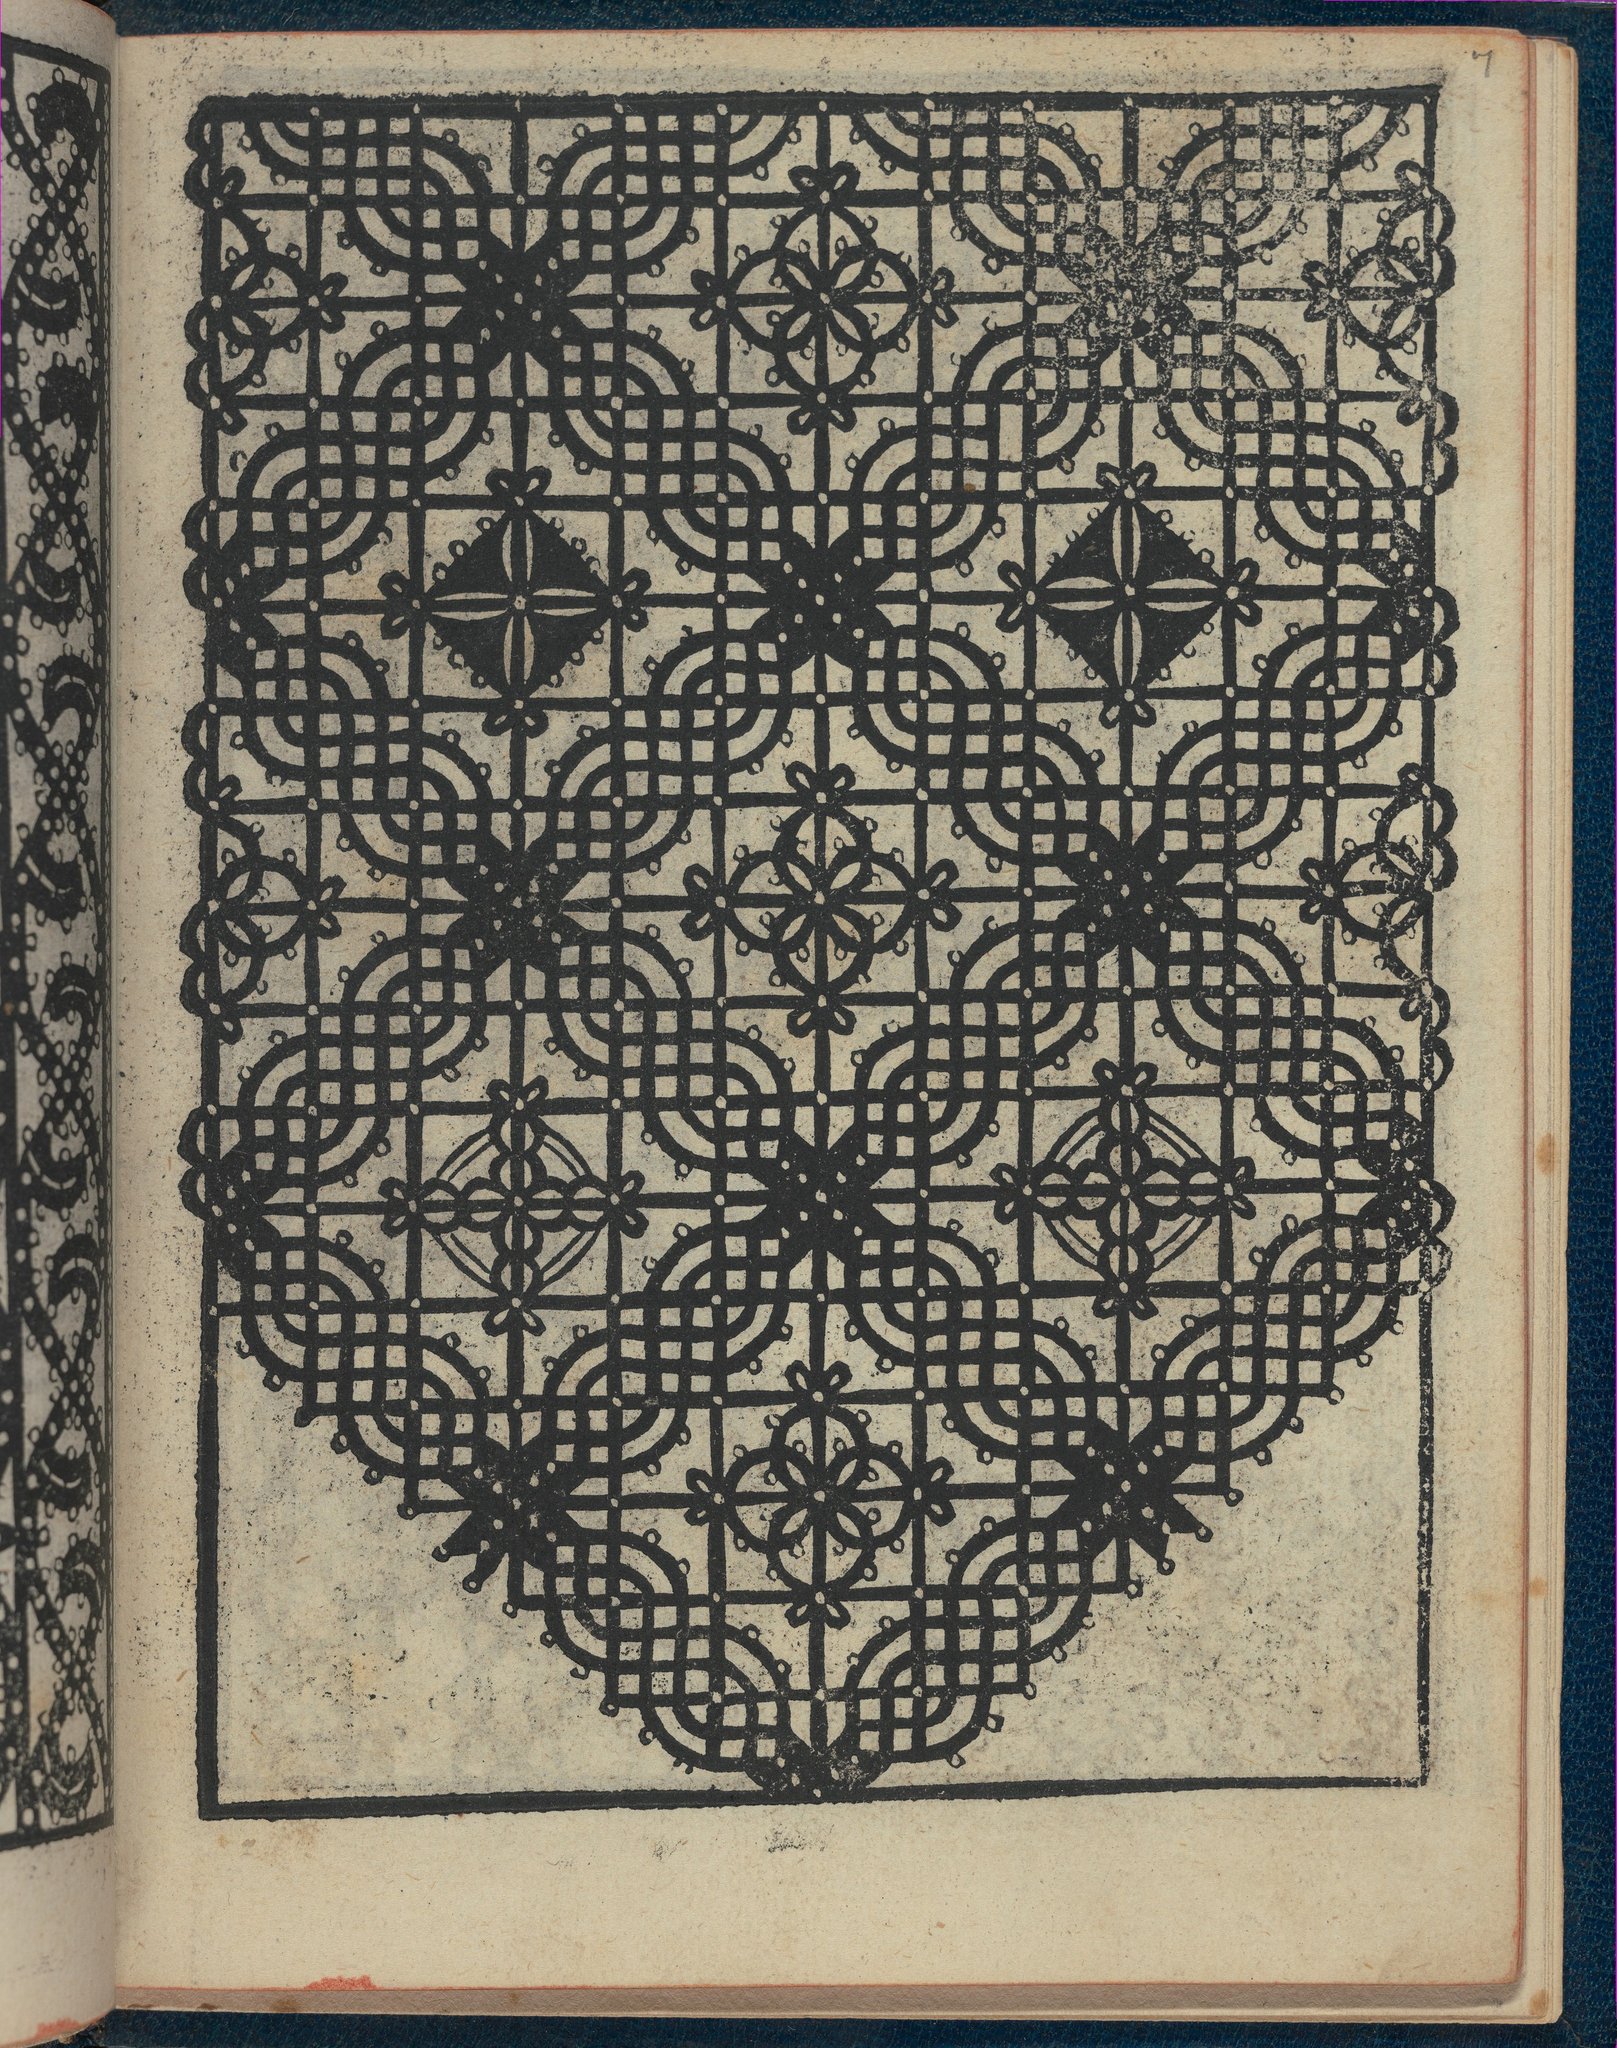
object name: book print ornament architecture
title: Le Pompe: Opera Nova, page 4 (recto)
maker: giovanni battista & marchio sessa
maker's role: publisher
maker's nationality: italian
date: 1557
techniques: woodcut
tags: ornament